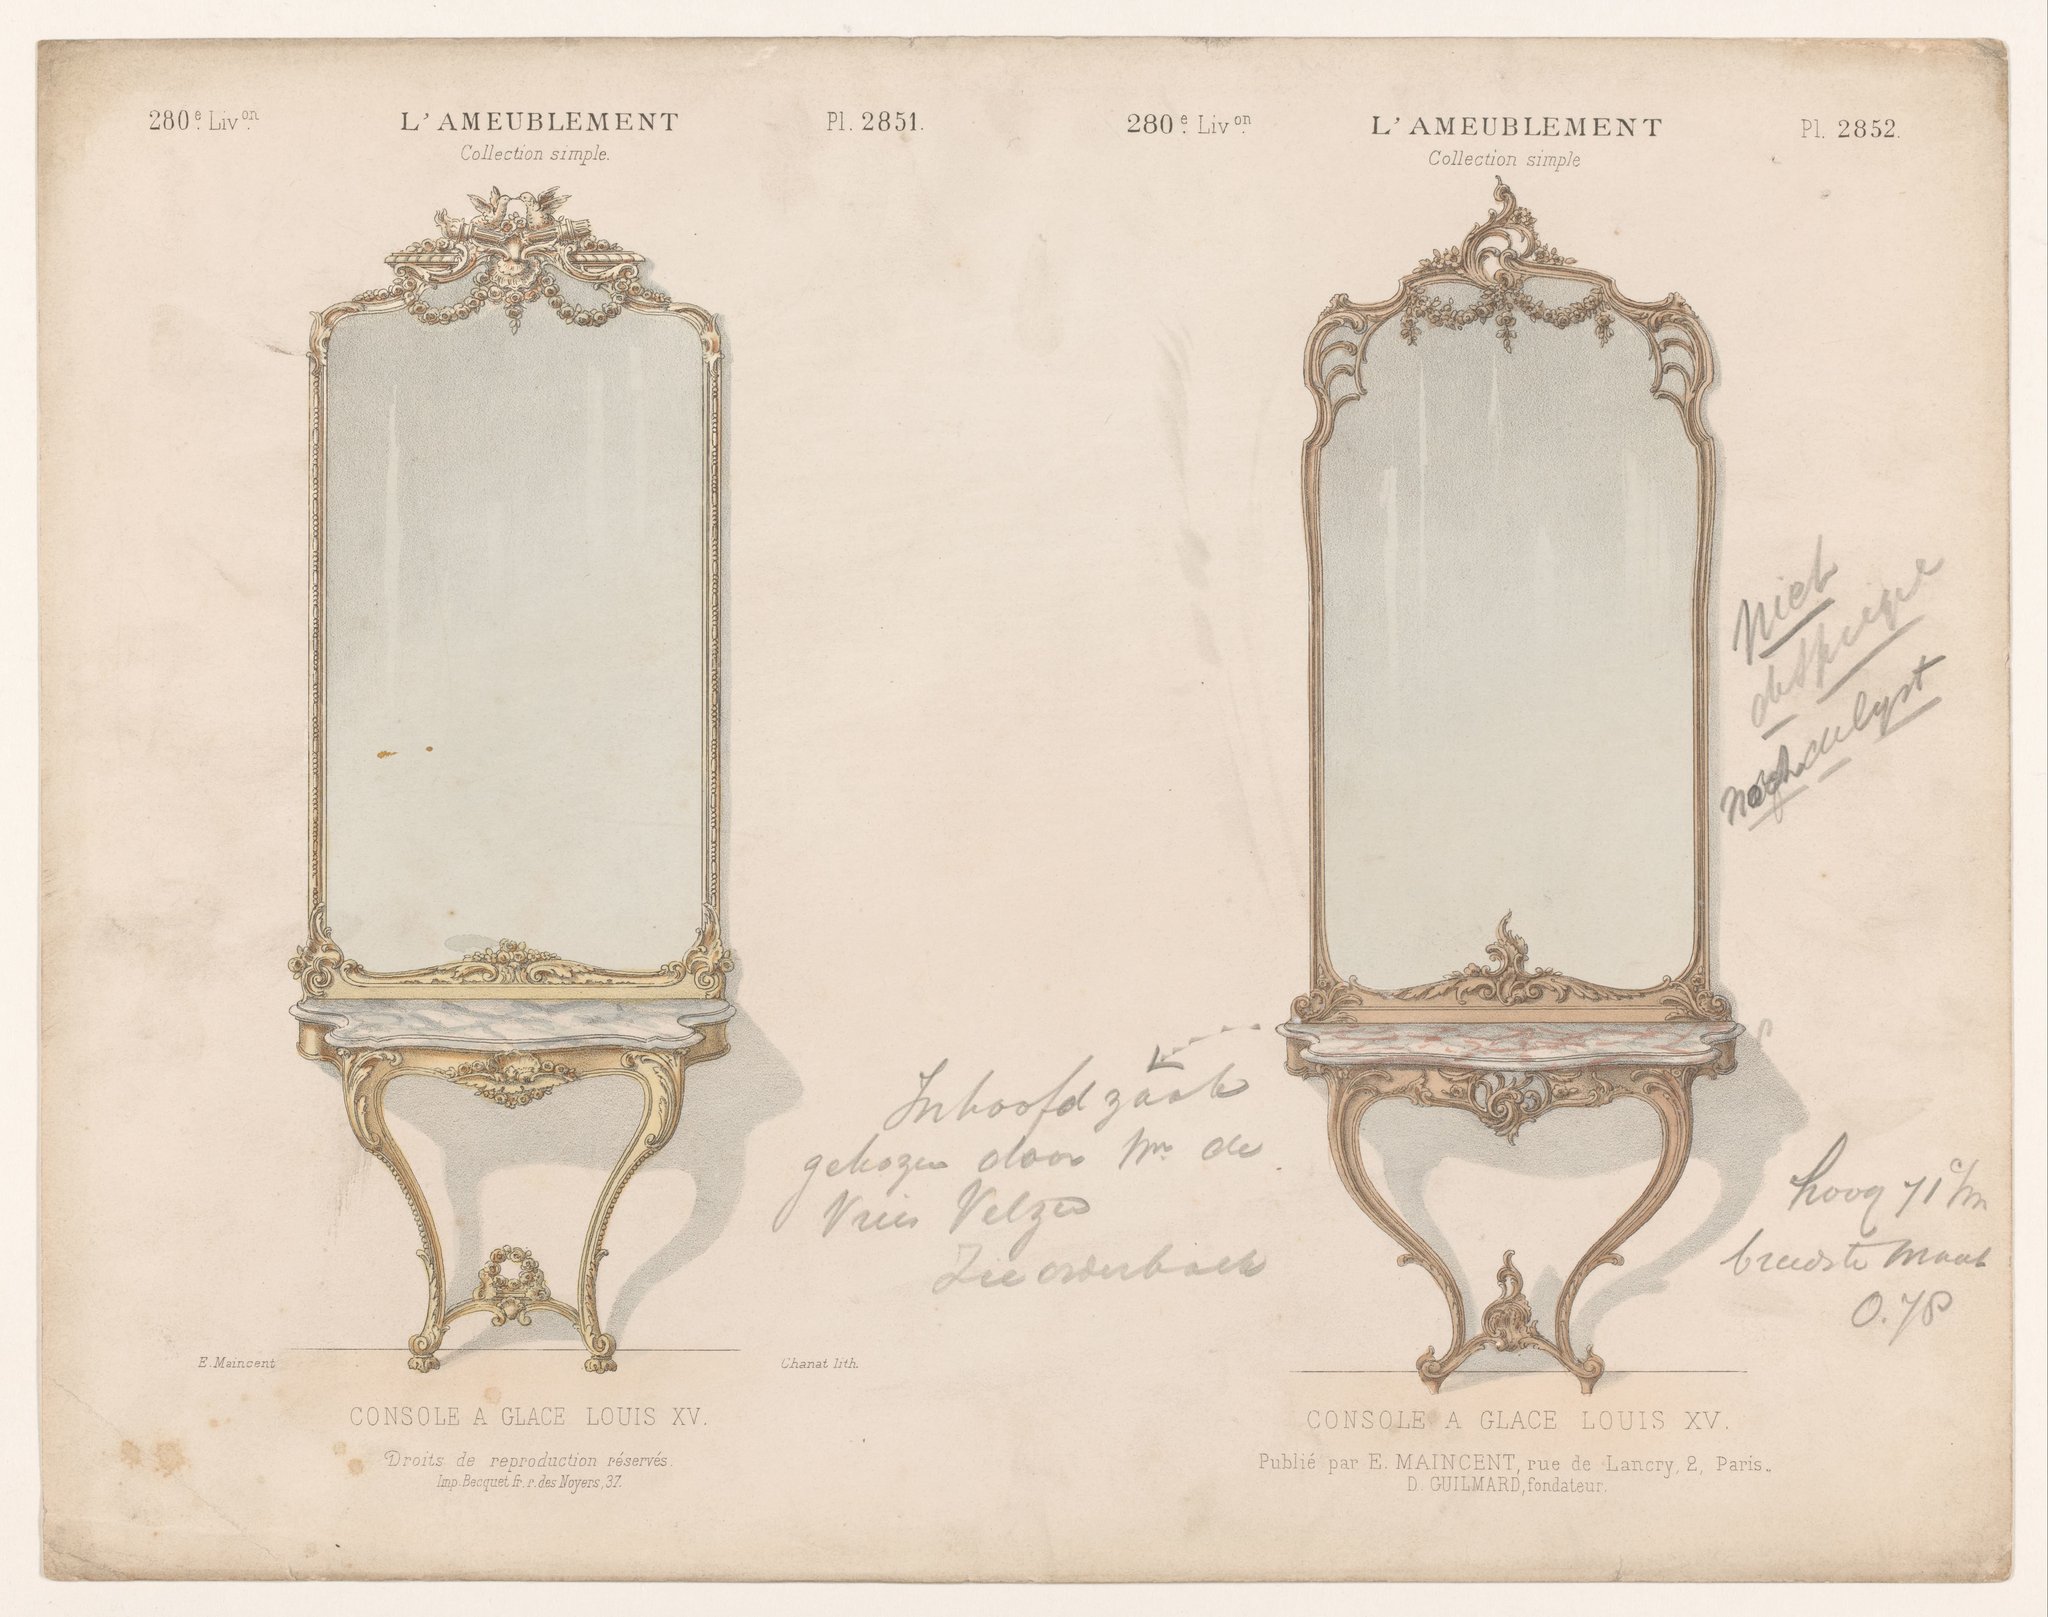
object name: print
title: Console a glace Louis XV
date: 1885-1895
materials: paper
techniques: hand coloring, lithograph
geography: paris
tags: mirror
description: Twee spiegels in de Lodewijk XV-stijl. Prent uit 280e Livraison.